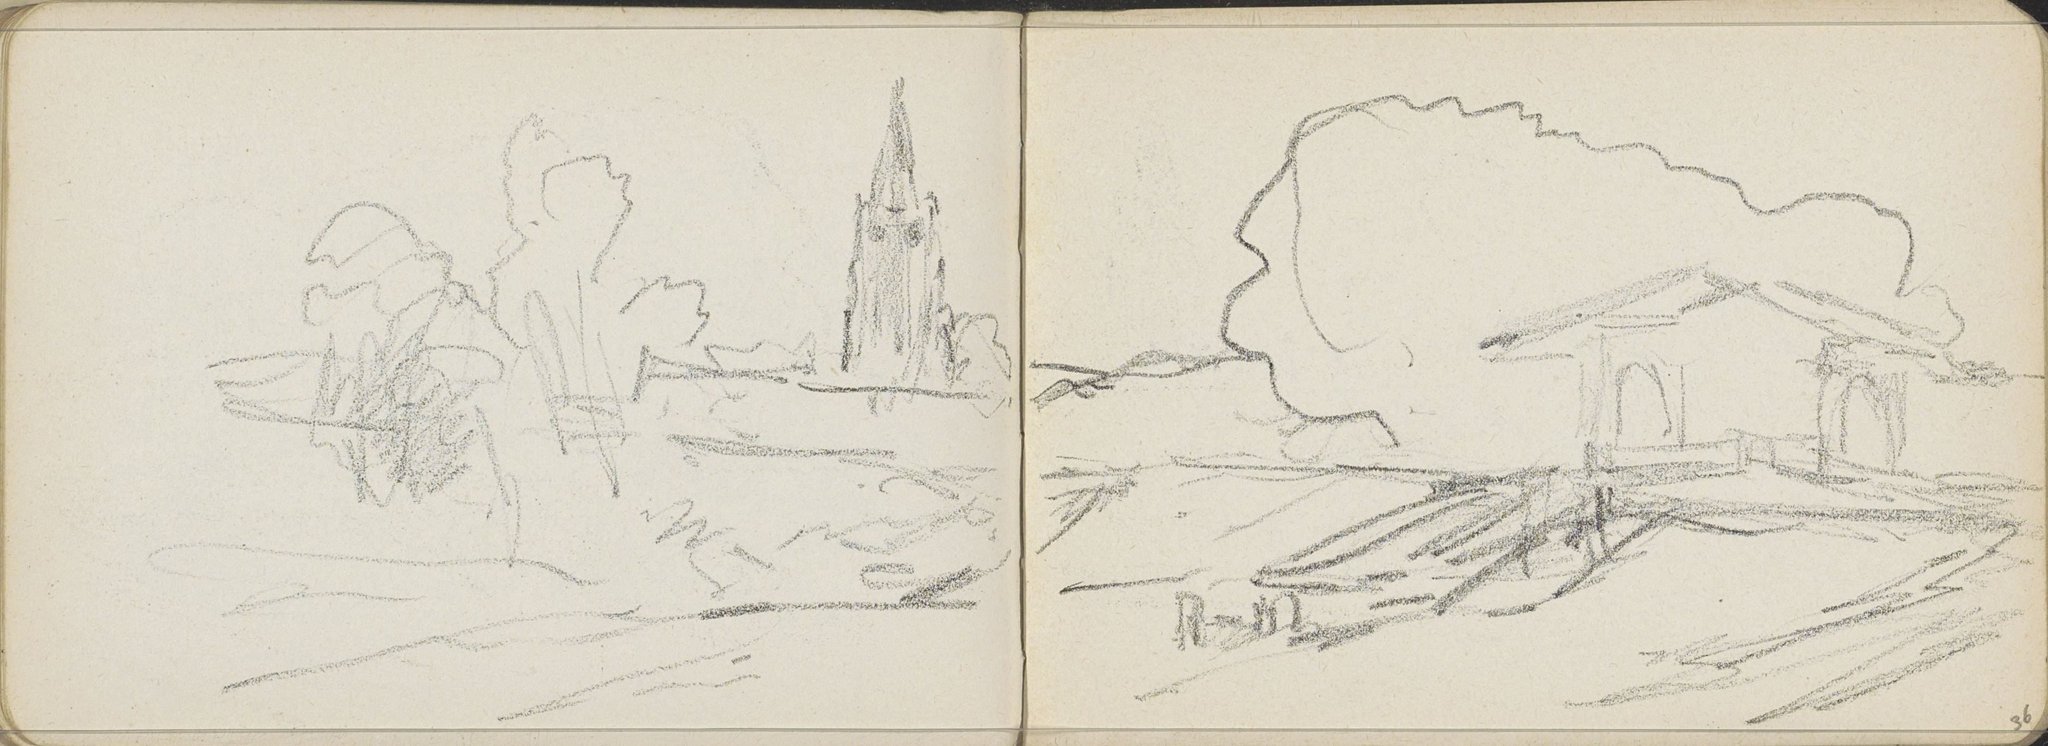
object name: sketchbook leaf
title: Landschap met een ophaalbrug en kerktoren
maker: willem cornelis rip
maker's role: draughtsman, painter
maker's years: 1856-1922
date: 1905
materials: chalk, paper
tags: city-view, and landscape with man-made constructions, bridge, parts of church exterior and annexes: tower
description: Blad 35 verso en 36 recto uit een schetsboek met 42 bladen.